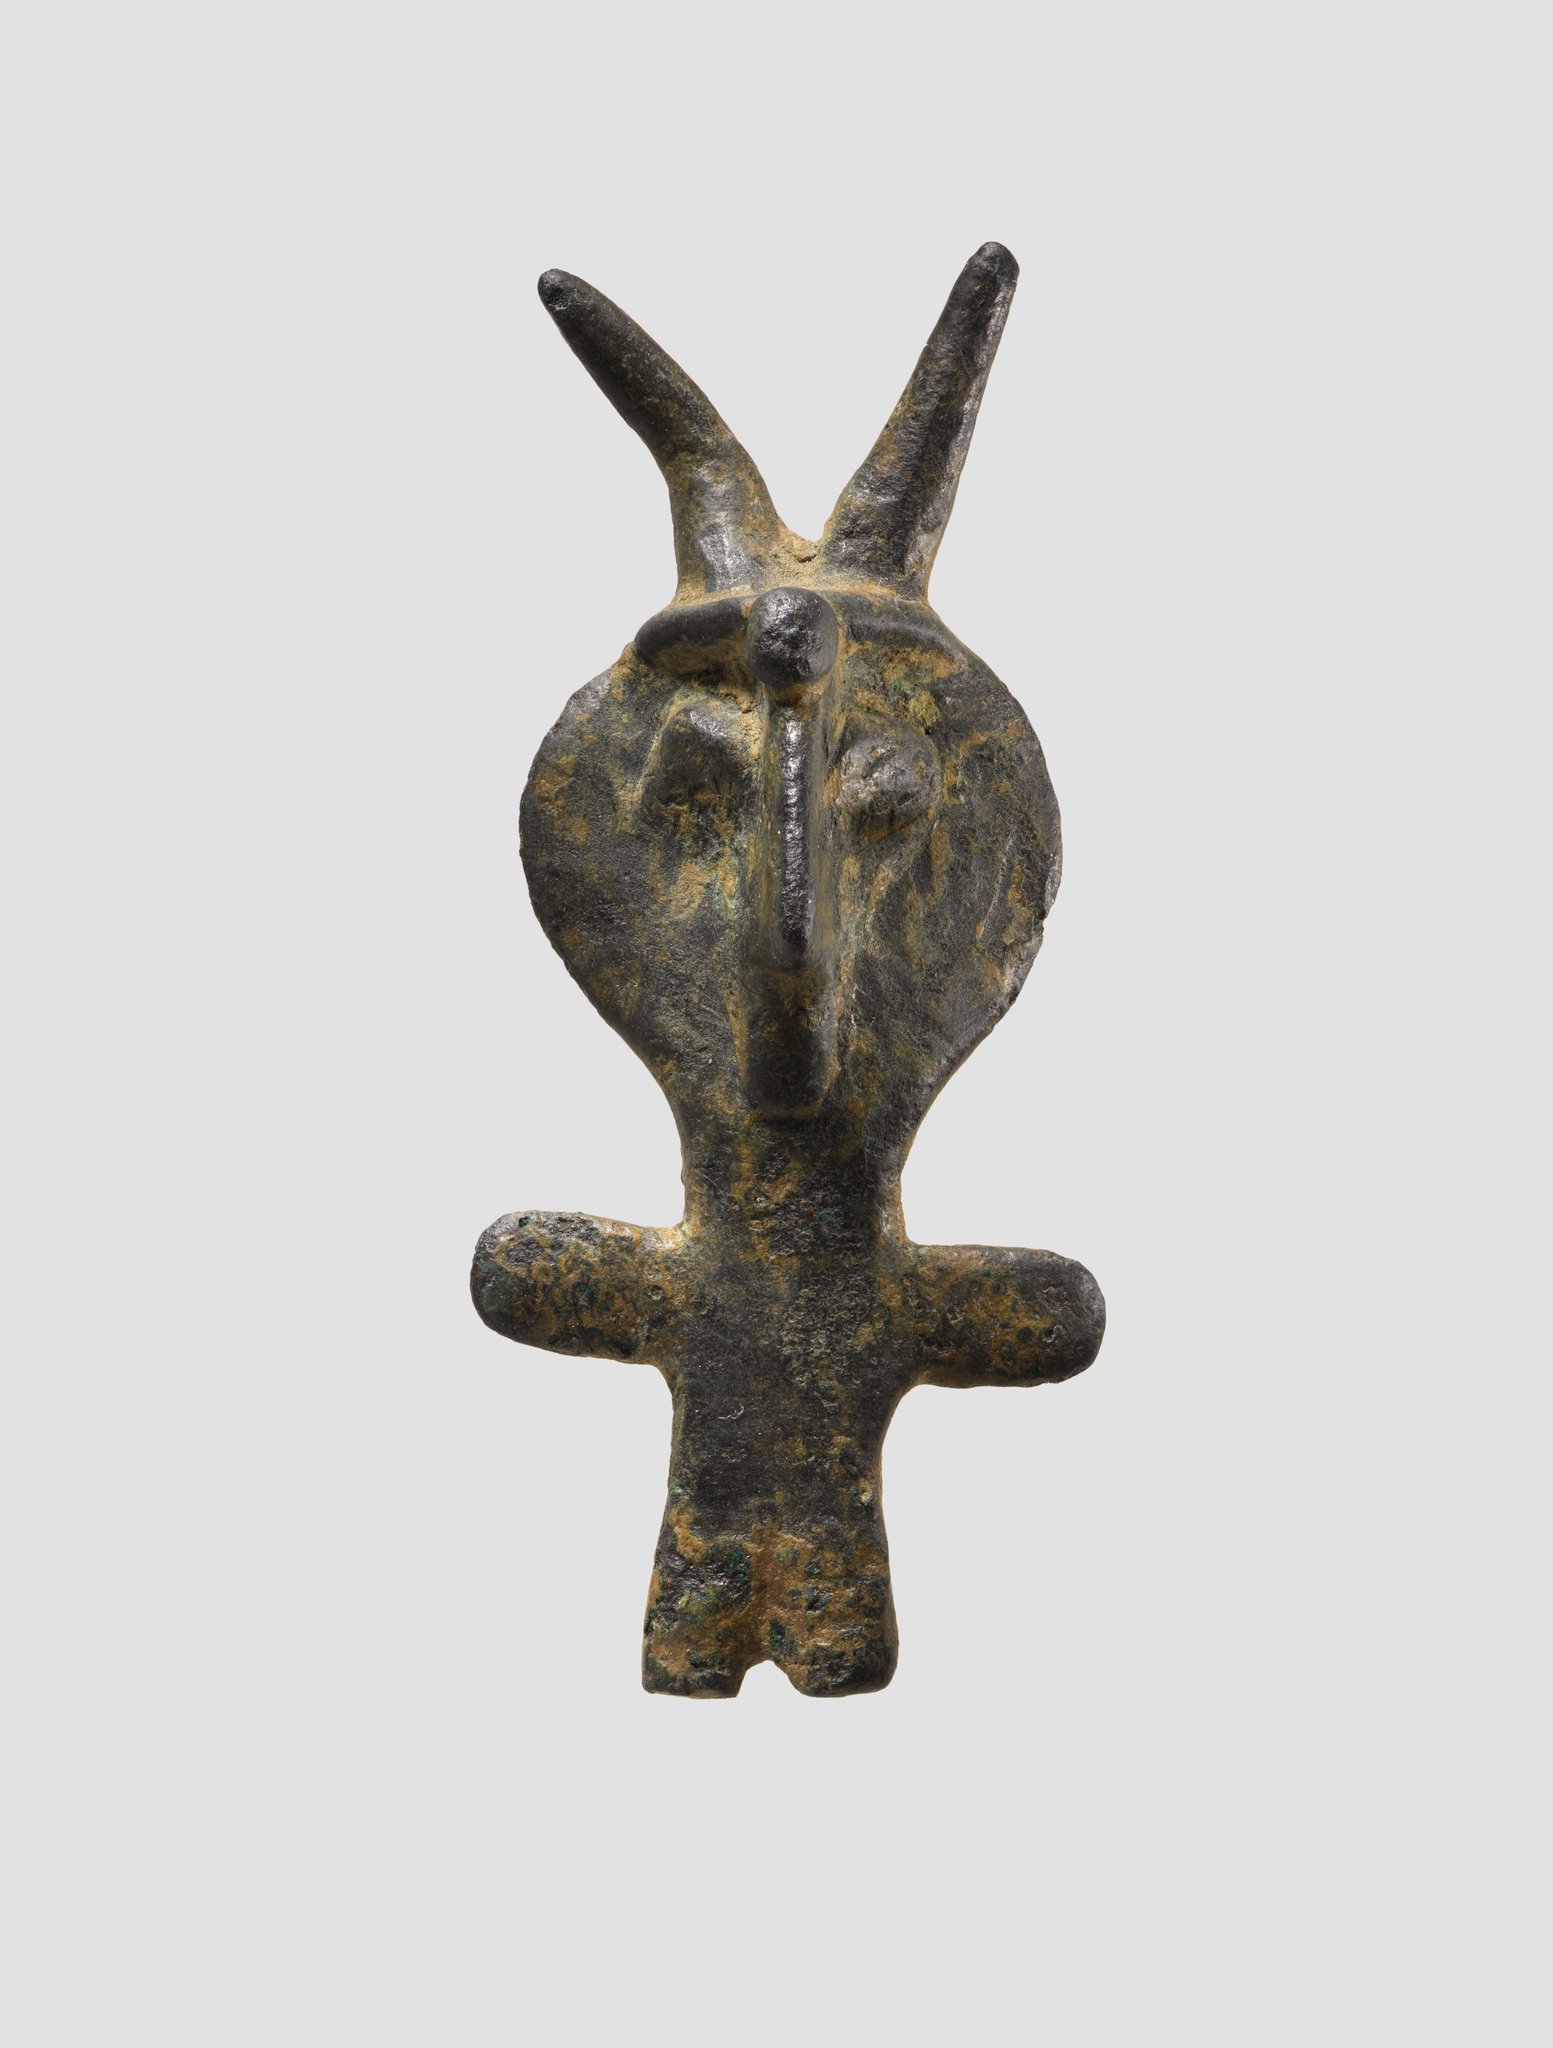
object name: sculpture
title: Figurine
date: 1000-1 BCE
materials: bronze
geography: western iran